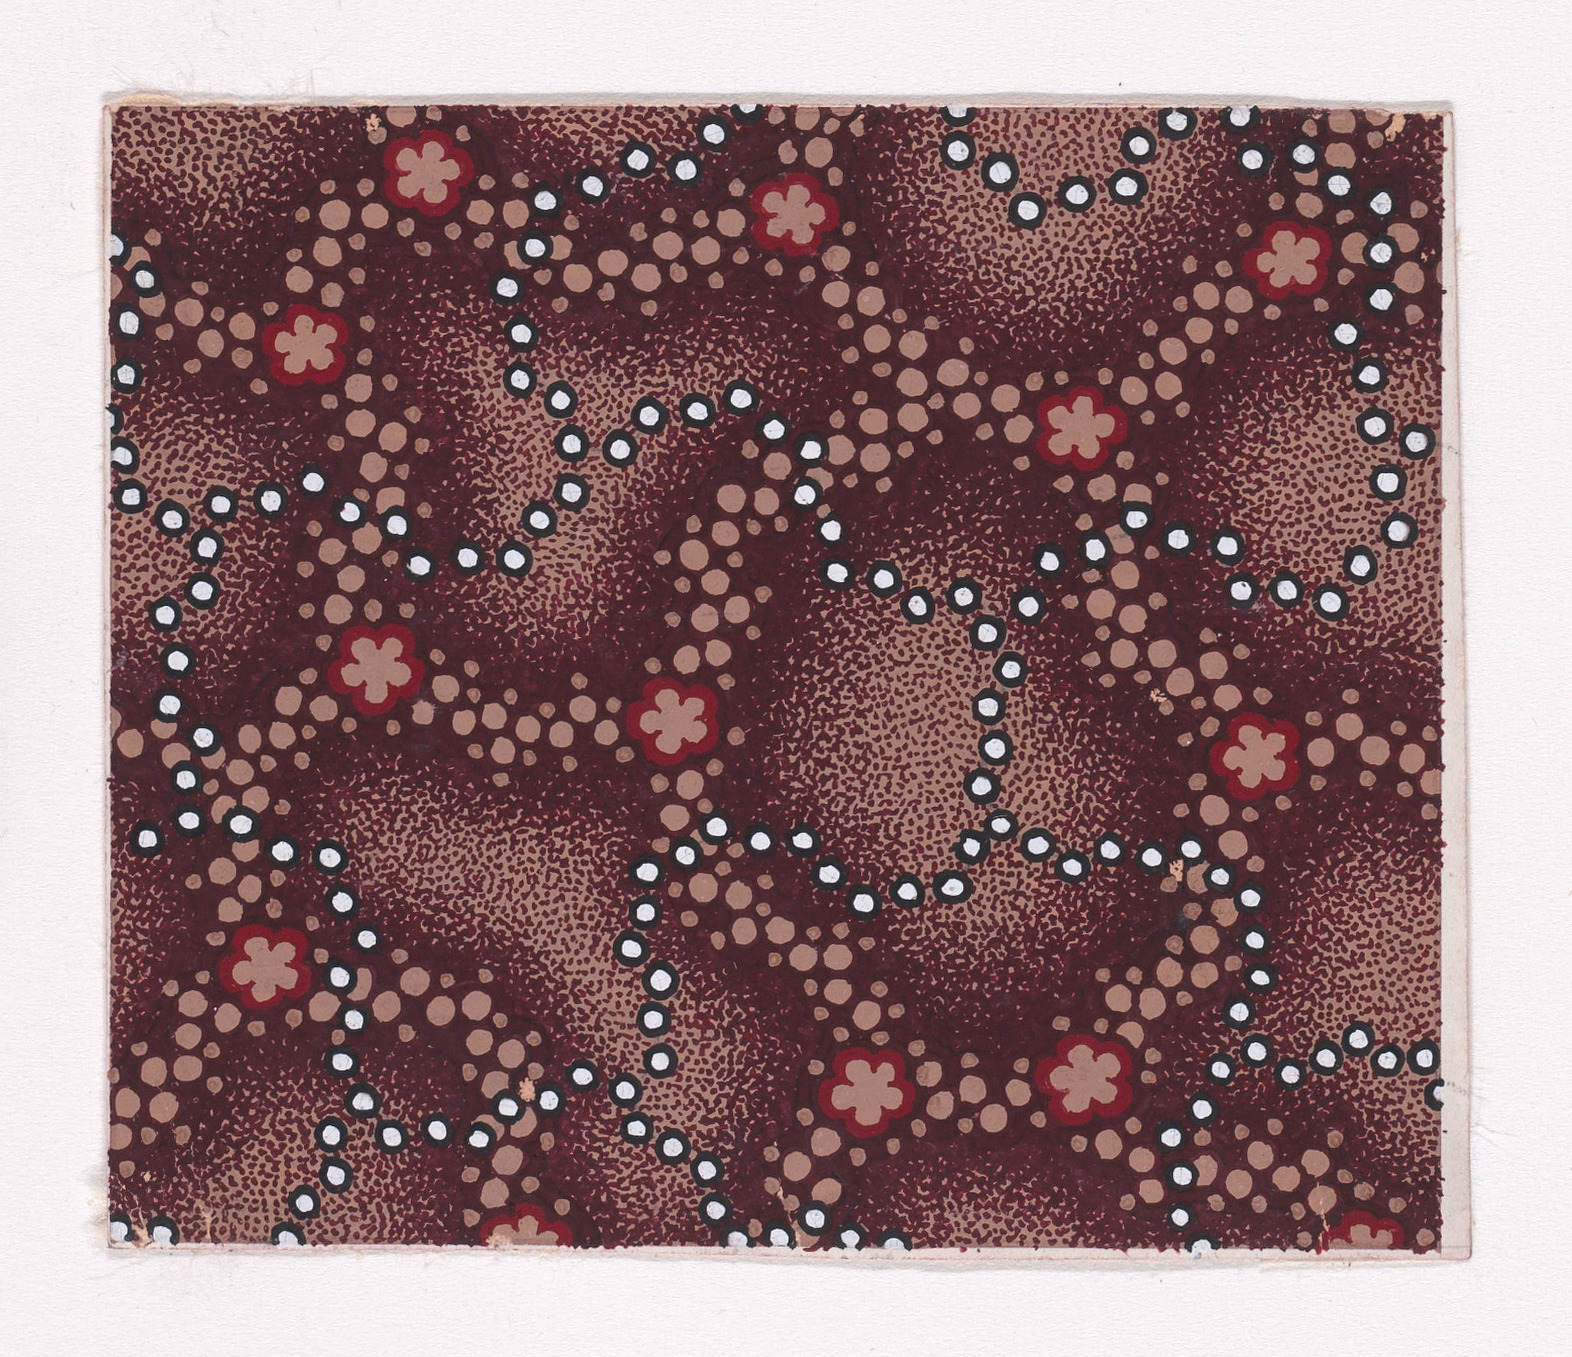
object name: drawing ornament architecture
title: Textile Design with Interlacing Strips of Pearls over Interlacing Garlands of Dots and Rosettes over a Stippled Background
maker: anonymous, alsatian, 19th century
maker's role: artist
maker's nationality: alsatian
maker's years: 1800-1900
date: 1840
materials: gouache